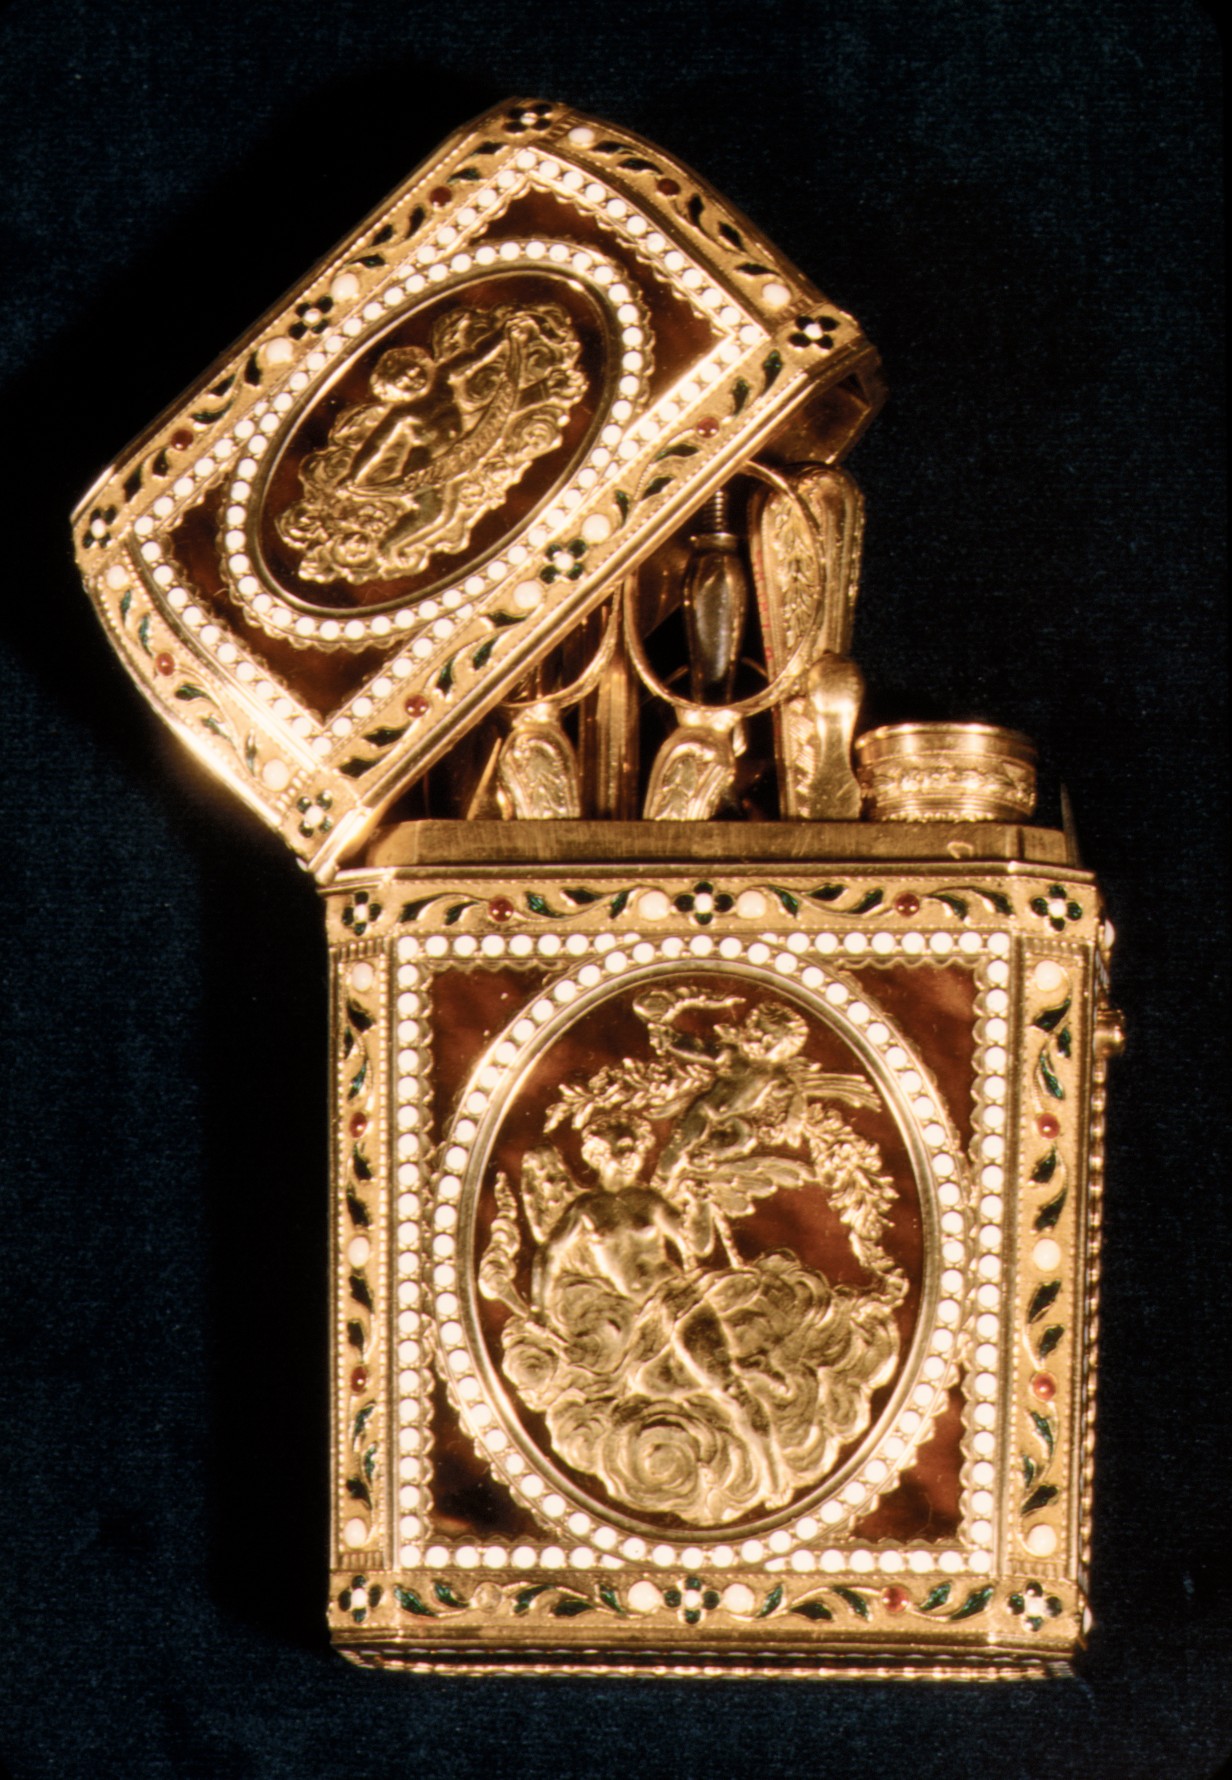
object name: nécessaire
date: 1701-1800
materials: enamel, gold, shell